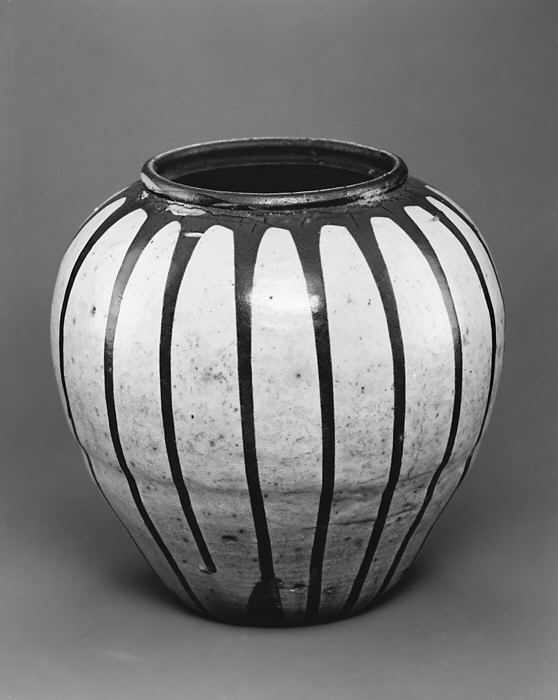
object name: jar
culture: japanese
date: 1800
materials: glaze, stoneware